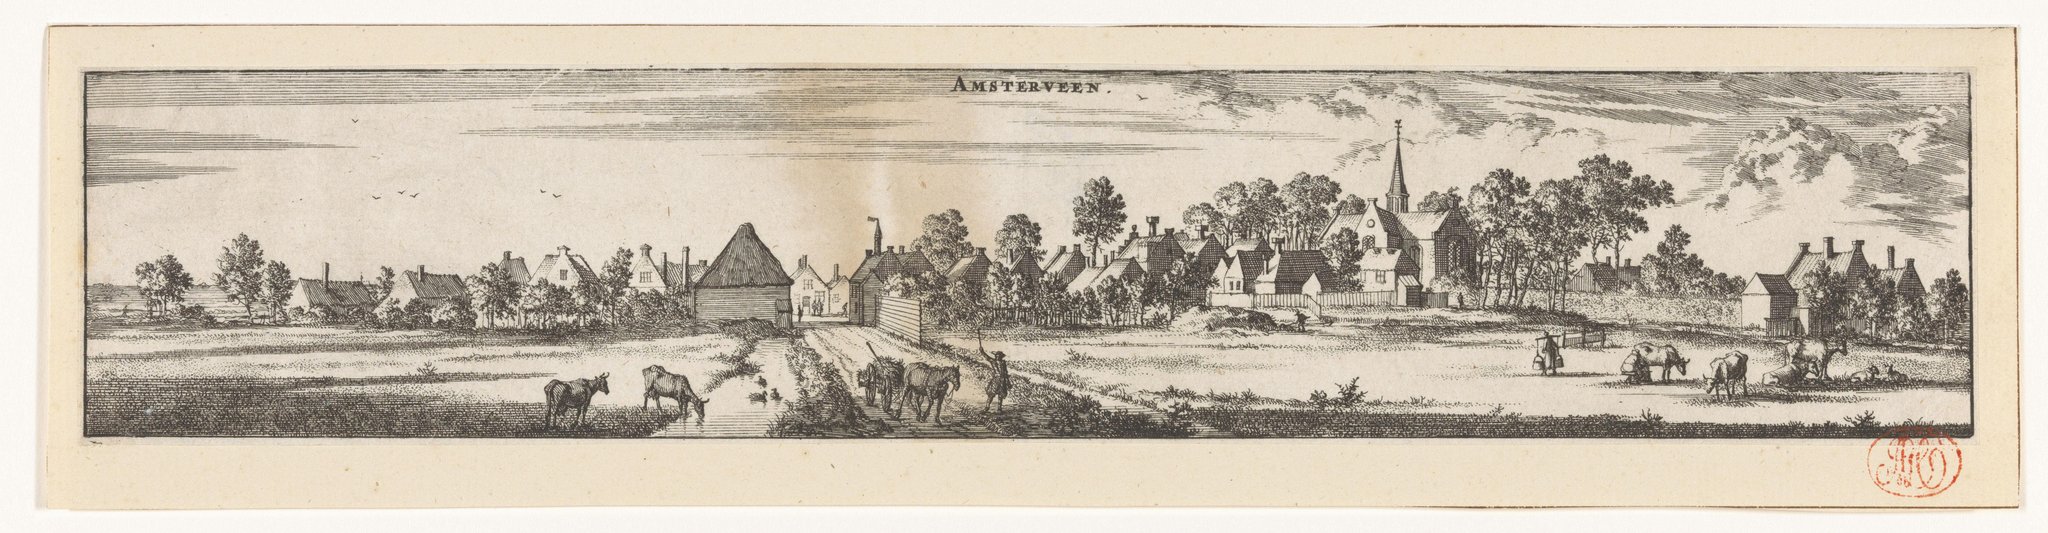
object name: print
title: Gezicht op Amstelveen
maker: jan luyken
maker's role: draughtsman, print maker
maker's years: 1649-1712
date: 1693-1726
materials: paper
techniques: etching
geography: amsterdam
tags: prospect of village, silhouette of village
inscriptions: collector's mark: Lugt 195, collector's mark: Lugt 2233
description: Deze afbeelding is afgesneden van een prent met vier voorstellingen (zie RP-P-1896-A-19368-940). Zie ook RP-P-AO-9-52 en RP-P-AO-9-58. De hele prent is ook gebruikt in: Commelin, Caspar. Beschryvinge van Amsterdam, desselfs eerste oorspronk uyt den Huyse (…). 2 delen. Amsterdam: Abraham Wolfgang, Gillis Janssonius van Waesberge, Johannes Janssonius van Waesberge II, weduwe Dirk Boom I, Hendrick Boom en Rembertus Goethals, 1693, dl. 2, p. 872. En in: Commelin, Caspar. Beschryvinge van Amsterdam, zynde een naukeurige verhandelinge van desselfs eerste oorspronk uyt (…). 2 delen. Amsterdam: weduwe Aart Dircksz Oossaan, 1694, dl. 2. En in: Commelin, Caspar. Beschryvinge van Amsterdam, zynde een naukeurige verhandelinge van desselfs eerste oorspronk uyt (…). 2 delen. 2e druk. Amsterdam: Andries van Damme, Johannes Ratelband, weduwe A. van Aaltwyk en Hermanus Uytwerf, 1726, dl. 2.